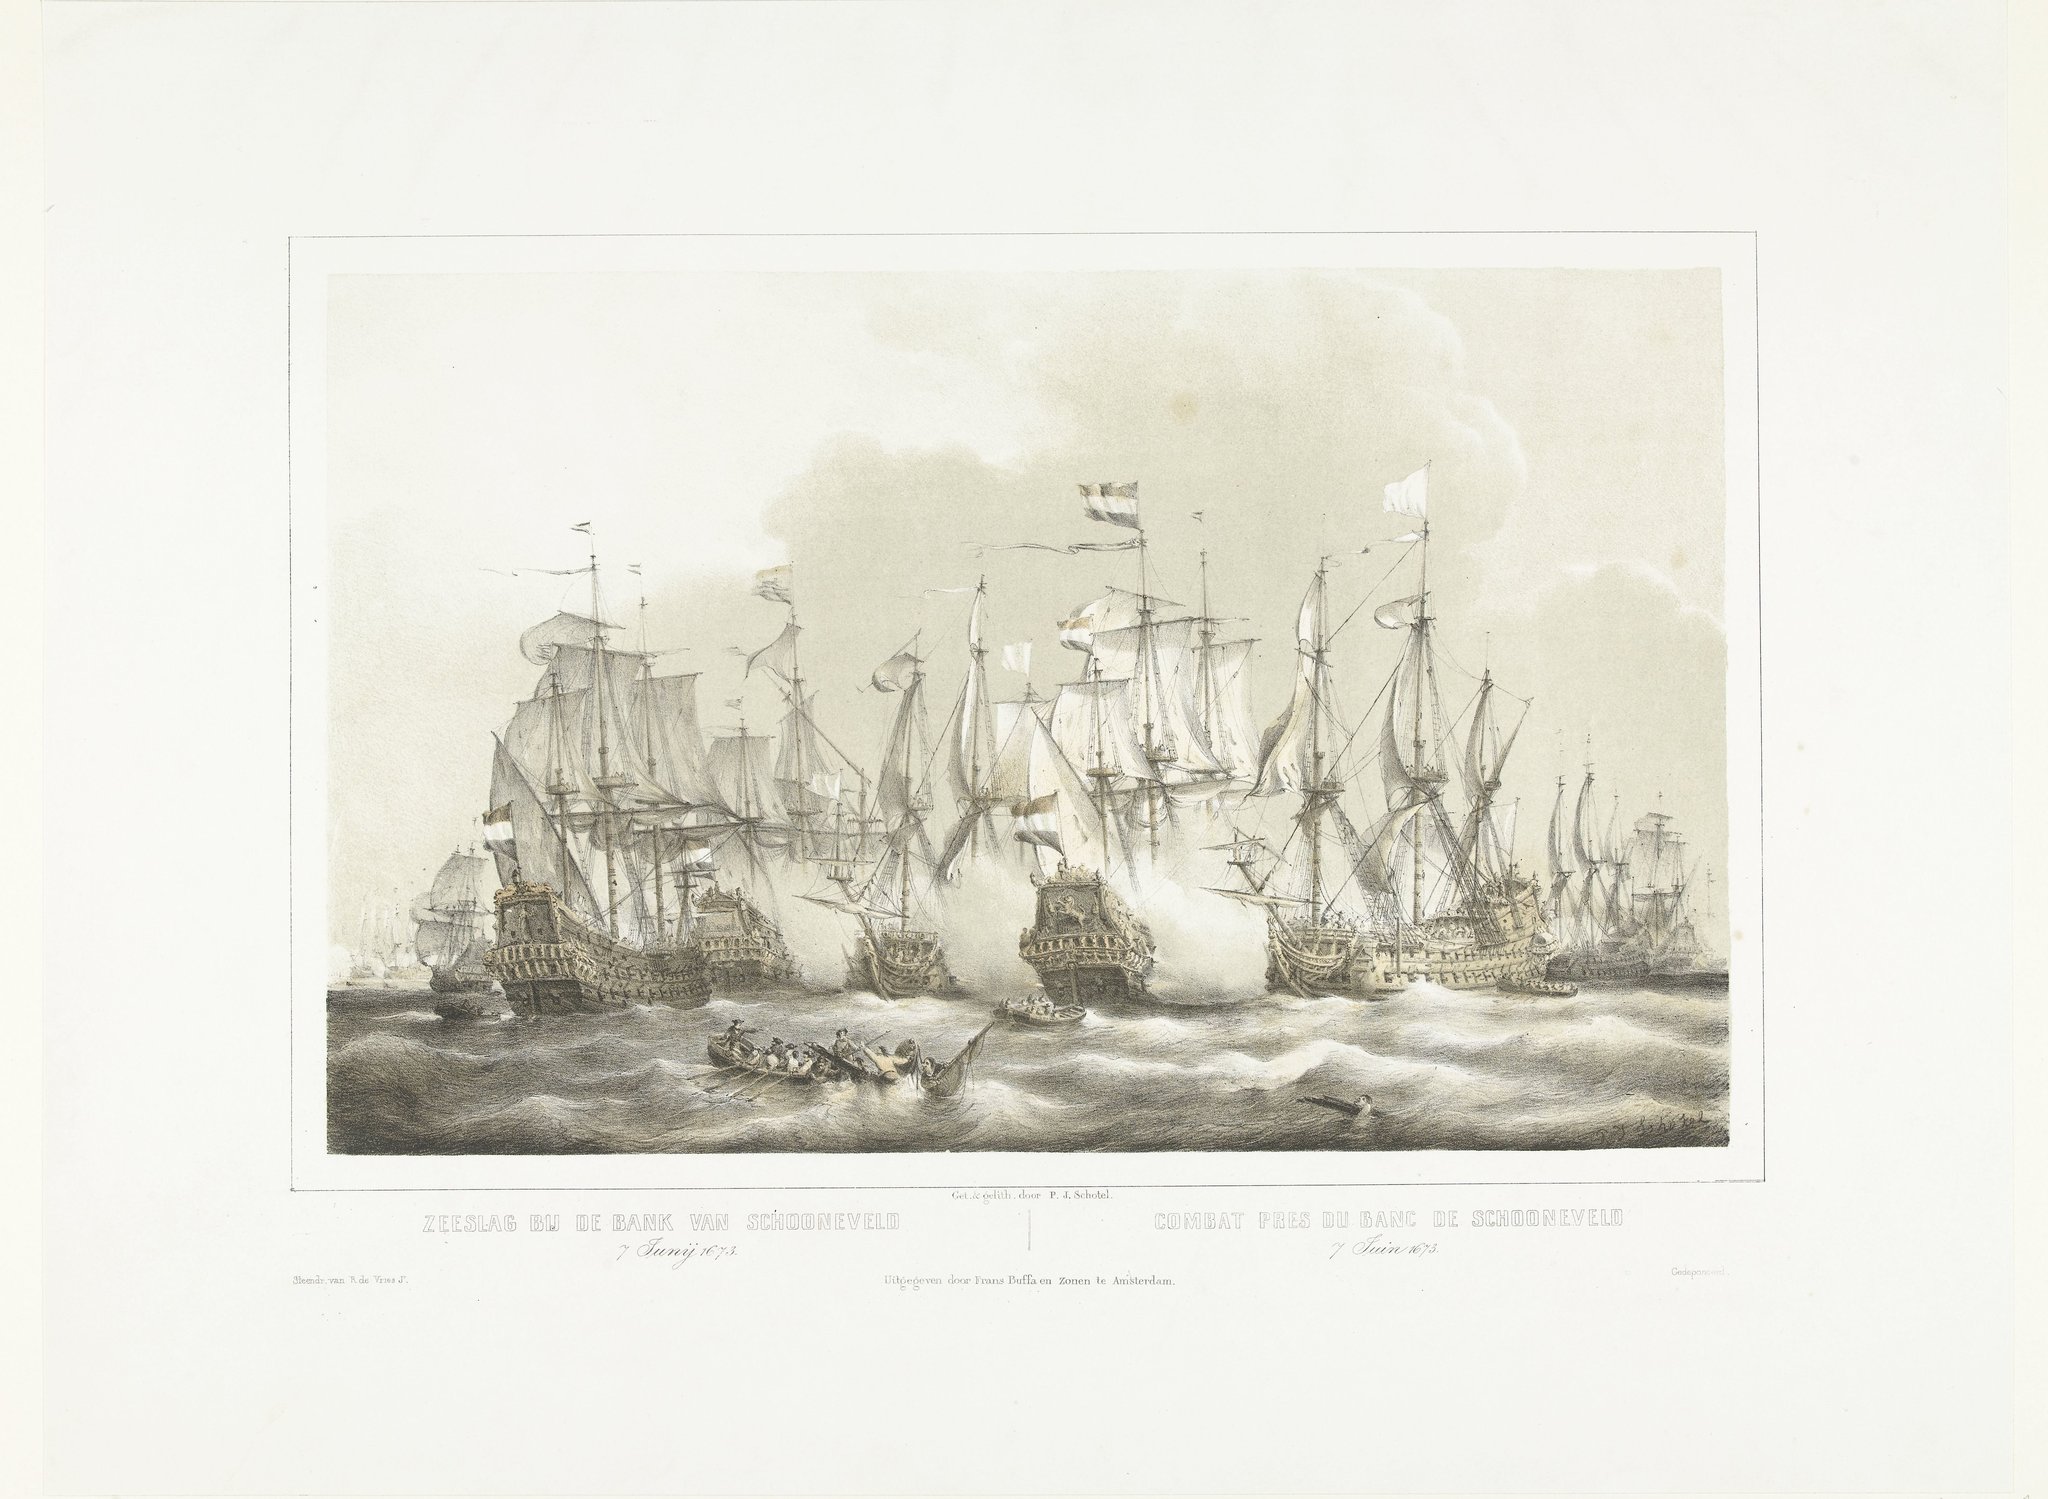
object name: history print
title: Zeeslag bij de bank van Schooneveld 7 junij 1673 / Combat pres du banc de Schooneveld 7 Juin 1673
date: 1848-1855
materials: paper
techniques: lithograph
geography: netherlands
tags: london, print maker, draughtsman, prinz ruprecht, flushing, michiel adriaenszoon de ruyter, rotterdam, cornelis tromp, battle (+ naval force), first battle of schooneveld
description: De zeeslag voor de Zeeuwse kust op de vlakte van Schoonevelt op 7 juni 1673 tussen de vloot van de Republiek onder Michiel Adriaenszoon de Ruyter en Cornelis Tromp en de gecombineerde Engels-Franse vloot onder Prins Rupert en graaf Jean d'Estrées.